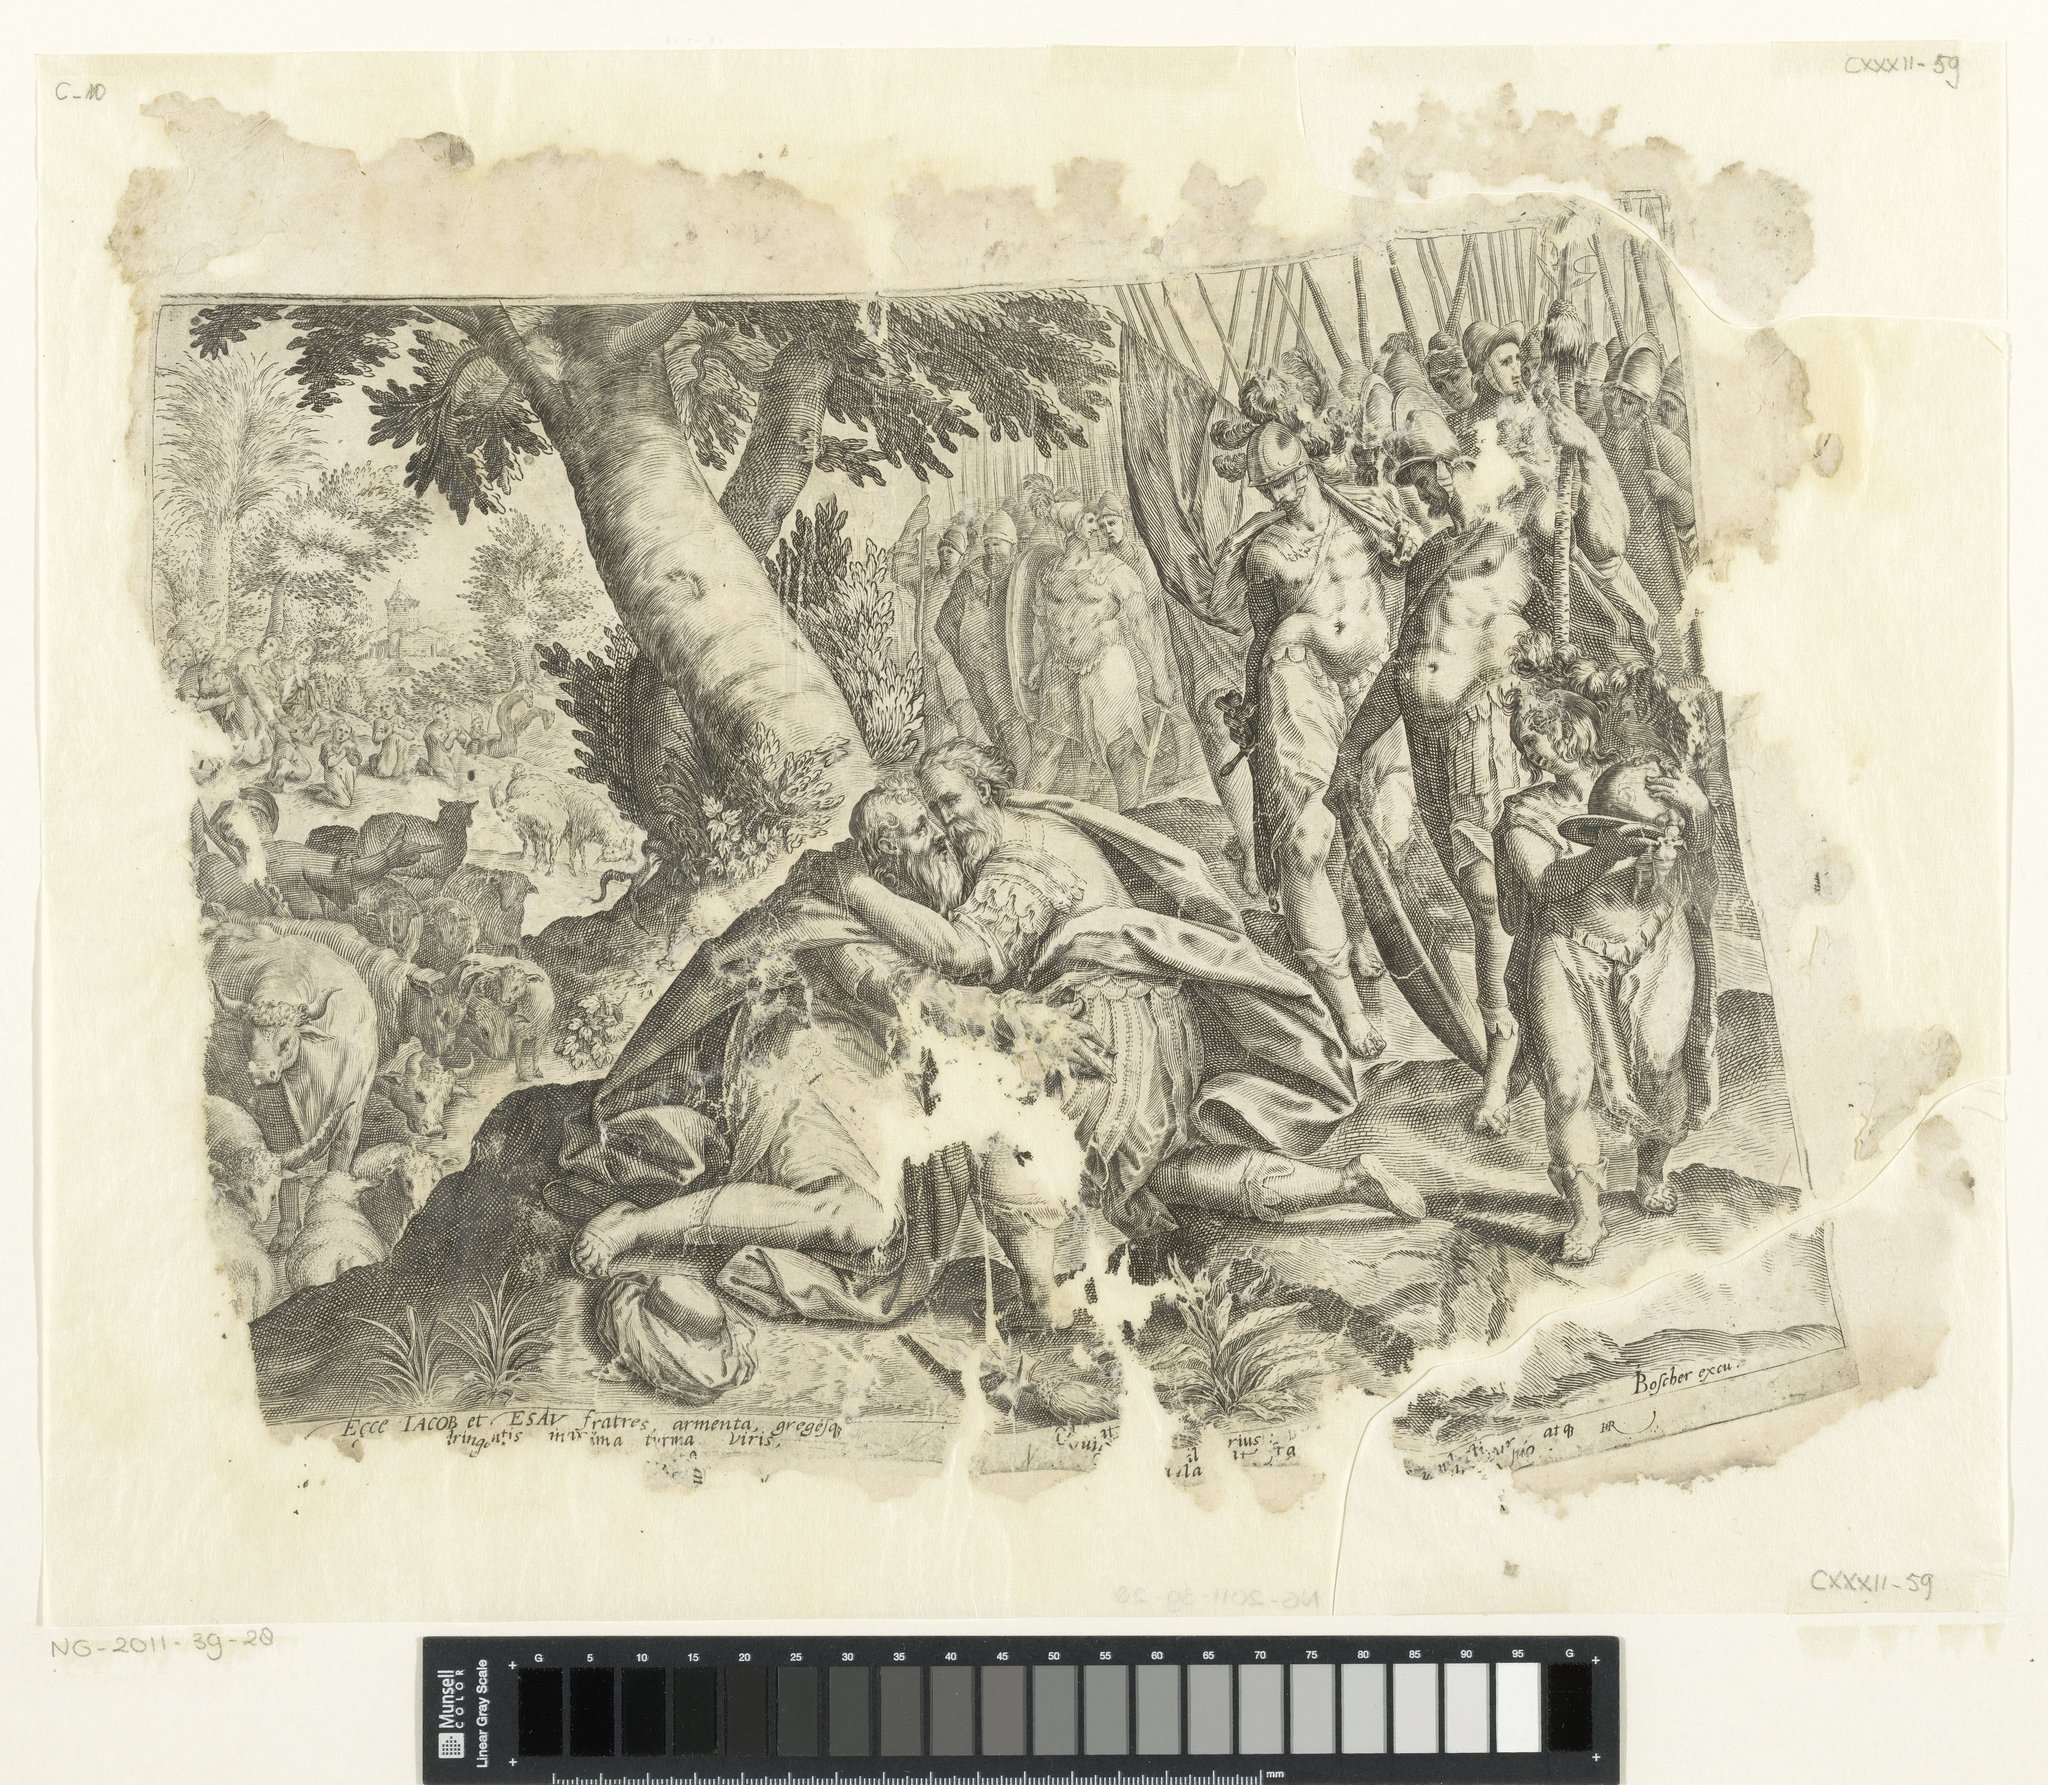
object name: print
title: Verzoening van Jakob en Esau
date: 1580-1596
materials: paper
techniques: engraving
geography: northern netherlands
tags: the meeting between esau and jacob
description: Tot dusverre was deze prent alleen bekend in een latere editie met het adres van C.J. Visscher in het door hem uitgegeven Theatrum Biblicum uit 1643, zie RP-P-1976-30-39. De prenten in de Nova Zembla collectie zijn tijdens een expeditie van Willem Barendsz en Jacob van Heemskerk in 1596-1597 noodgedwongen in het winterkamp, het ‘Behouden Huis’, op het eiland achtergelaten. De prenten waren in één of meerdere stapels als handelswaar meegenomen vanuit Amsterdam. Bijna drie eeuwen later, in 1871, keerde de Noor Elling Carlsen terug naar Nova Zembla en vond daar de restanten van het ‘Behouden Huis, inclusief een groot deel van de inventaris. Een deel van de prenten, in de vorm van aaneengekoekte kluiten, werd toen ook teruggevonden. De papierkluiten waren soms op meerdere plekken gebroken. Tussen 1975-1979 zijn de prenten van elkaar gescheiden. Dit leverde in totaal ca. 1000 fragmenten van ca. 400 afdrukken van ca. 150 verschillende prenten op. Voor zover mogelijk zijn de fragmenten samengevoegd en zijn de prenten gereconstrueerd.